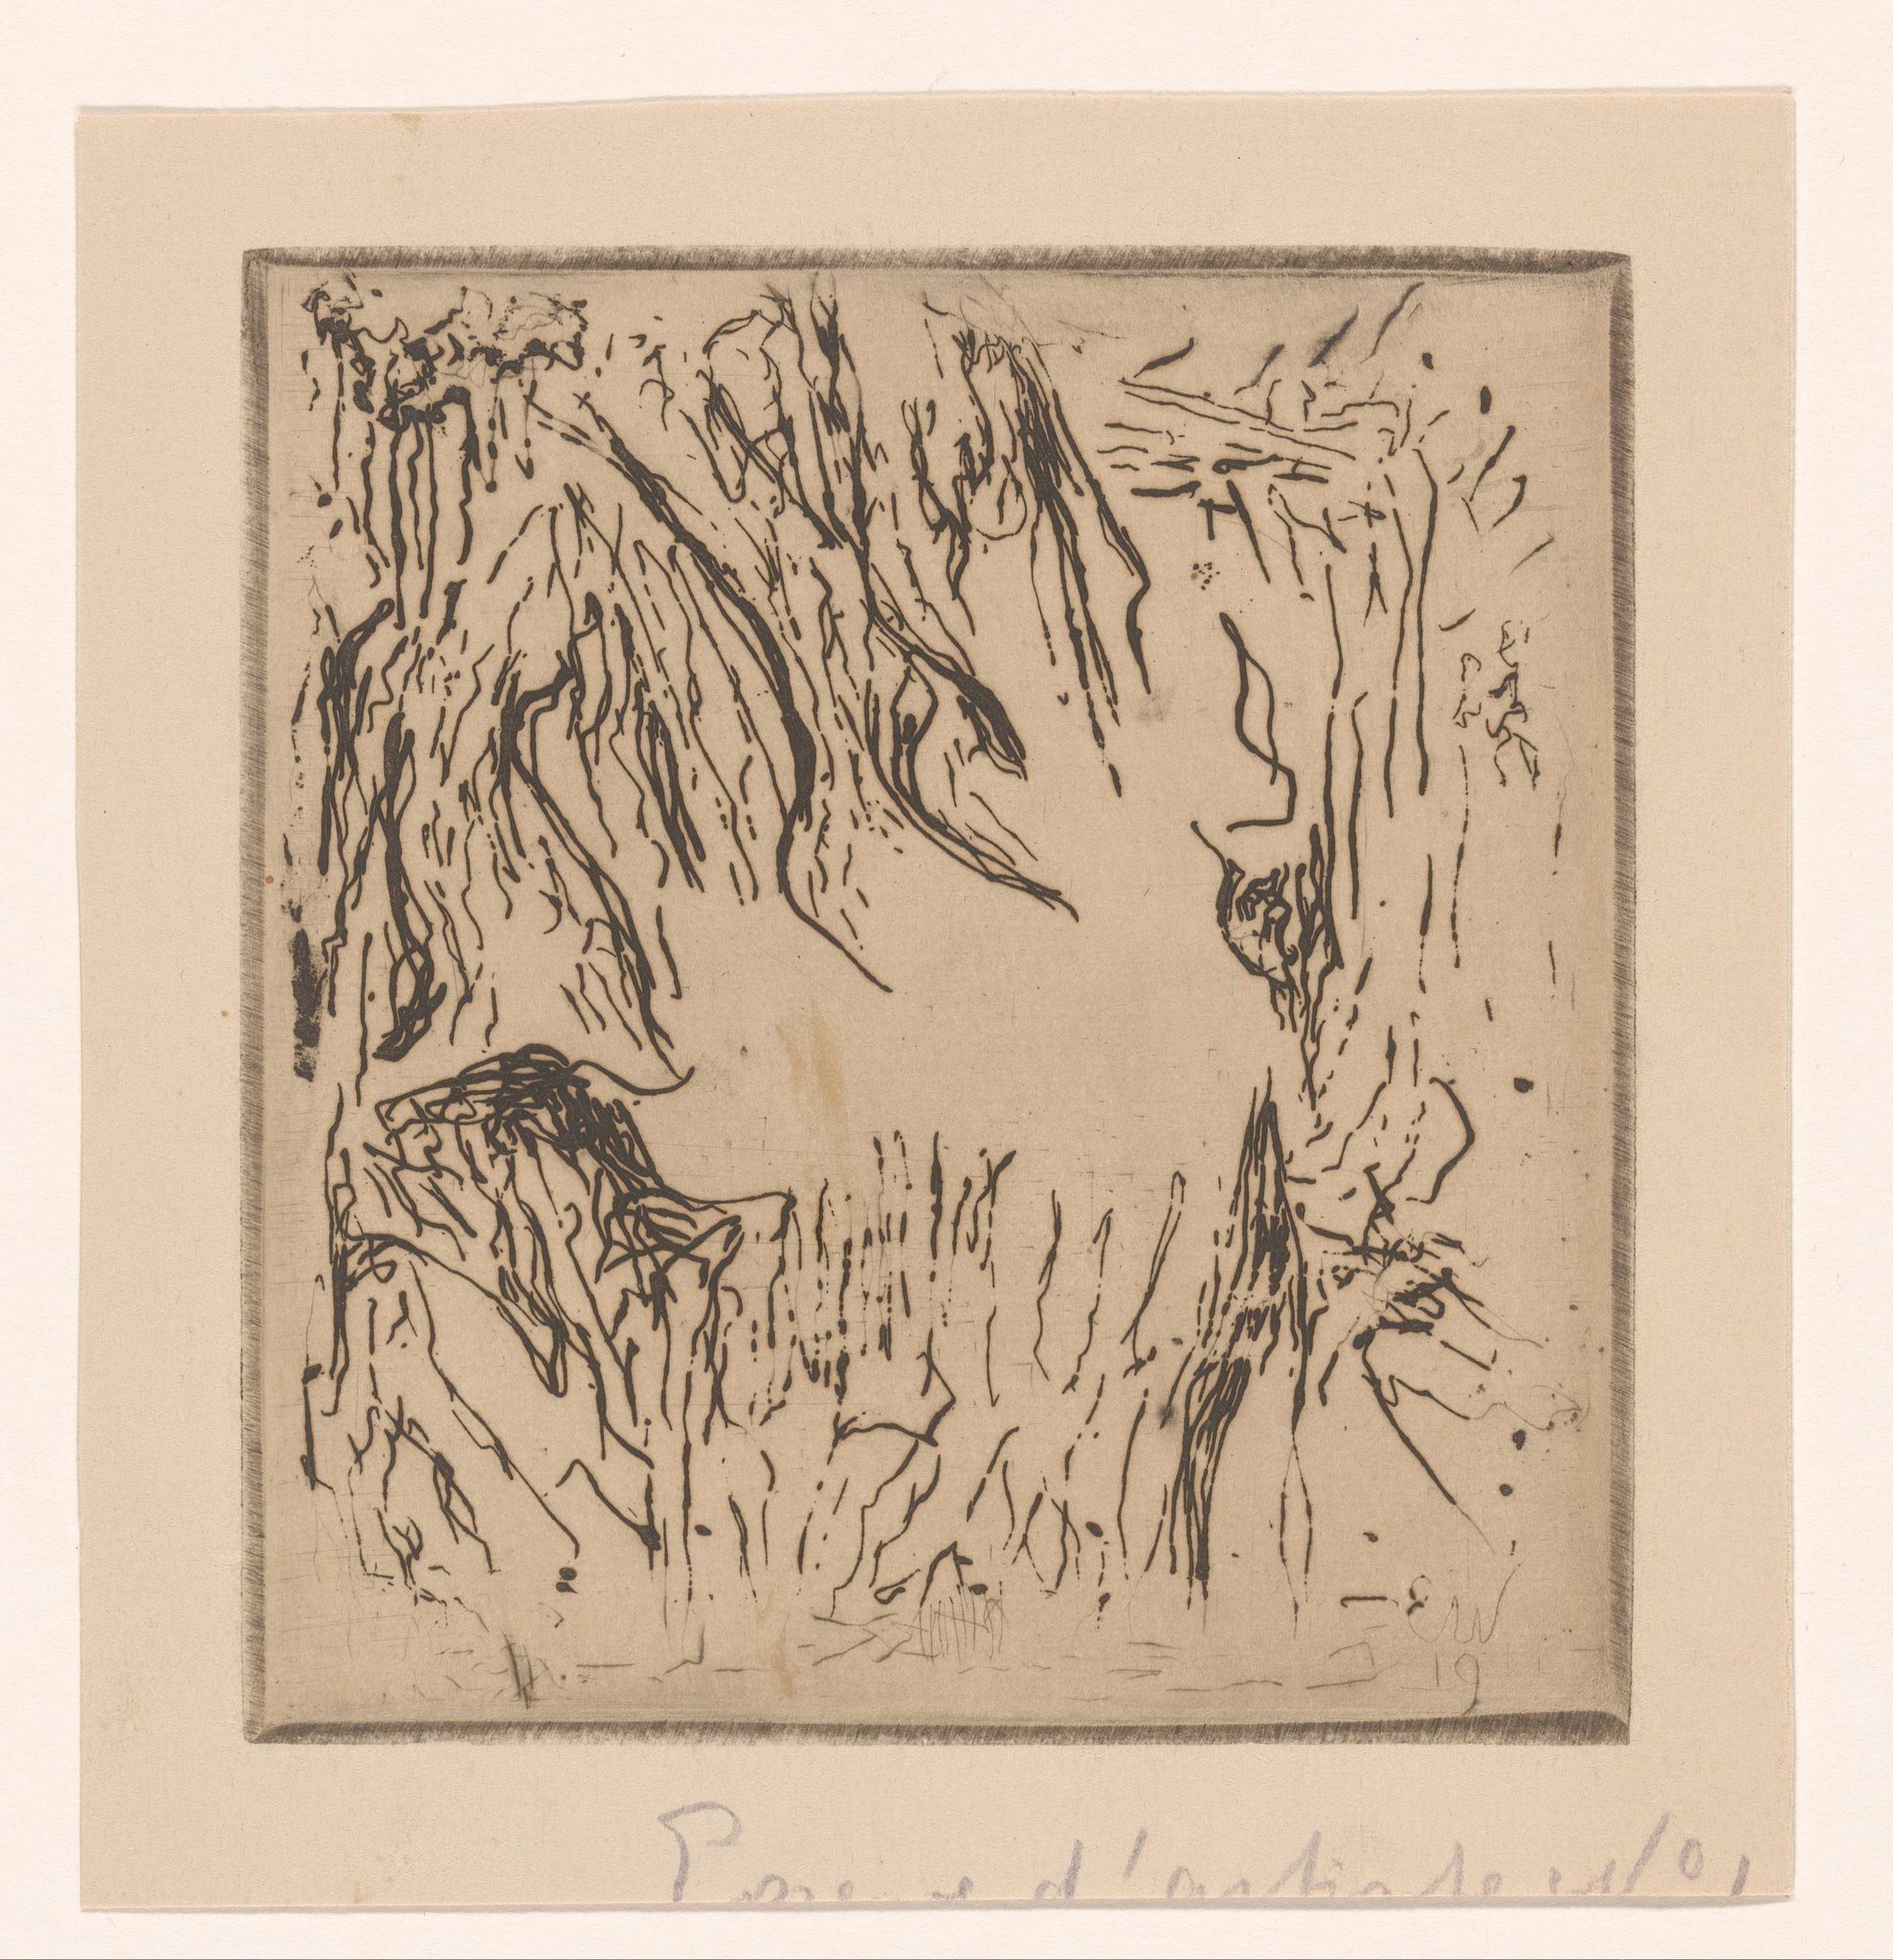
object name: print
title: Abstracte compositie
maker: erich wichmann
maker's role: print maker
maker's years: 1890-1929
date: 1919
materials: paper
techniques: etching, intaglio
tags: abstract, non-representational art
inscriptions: collector's mark: Lugt 2228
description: Prent mogelijk geïnspireerd op gedichten van Charles Baudelaire en Paul Verlaine.